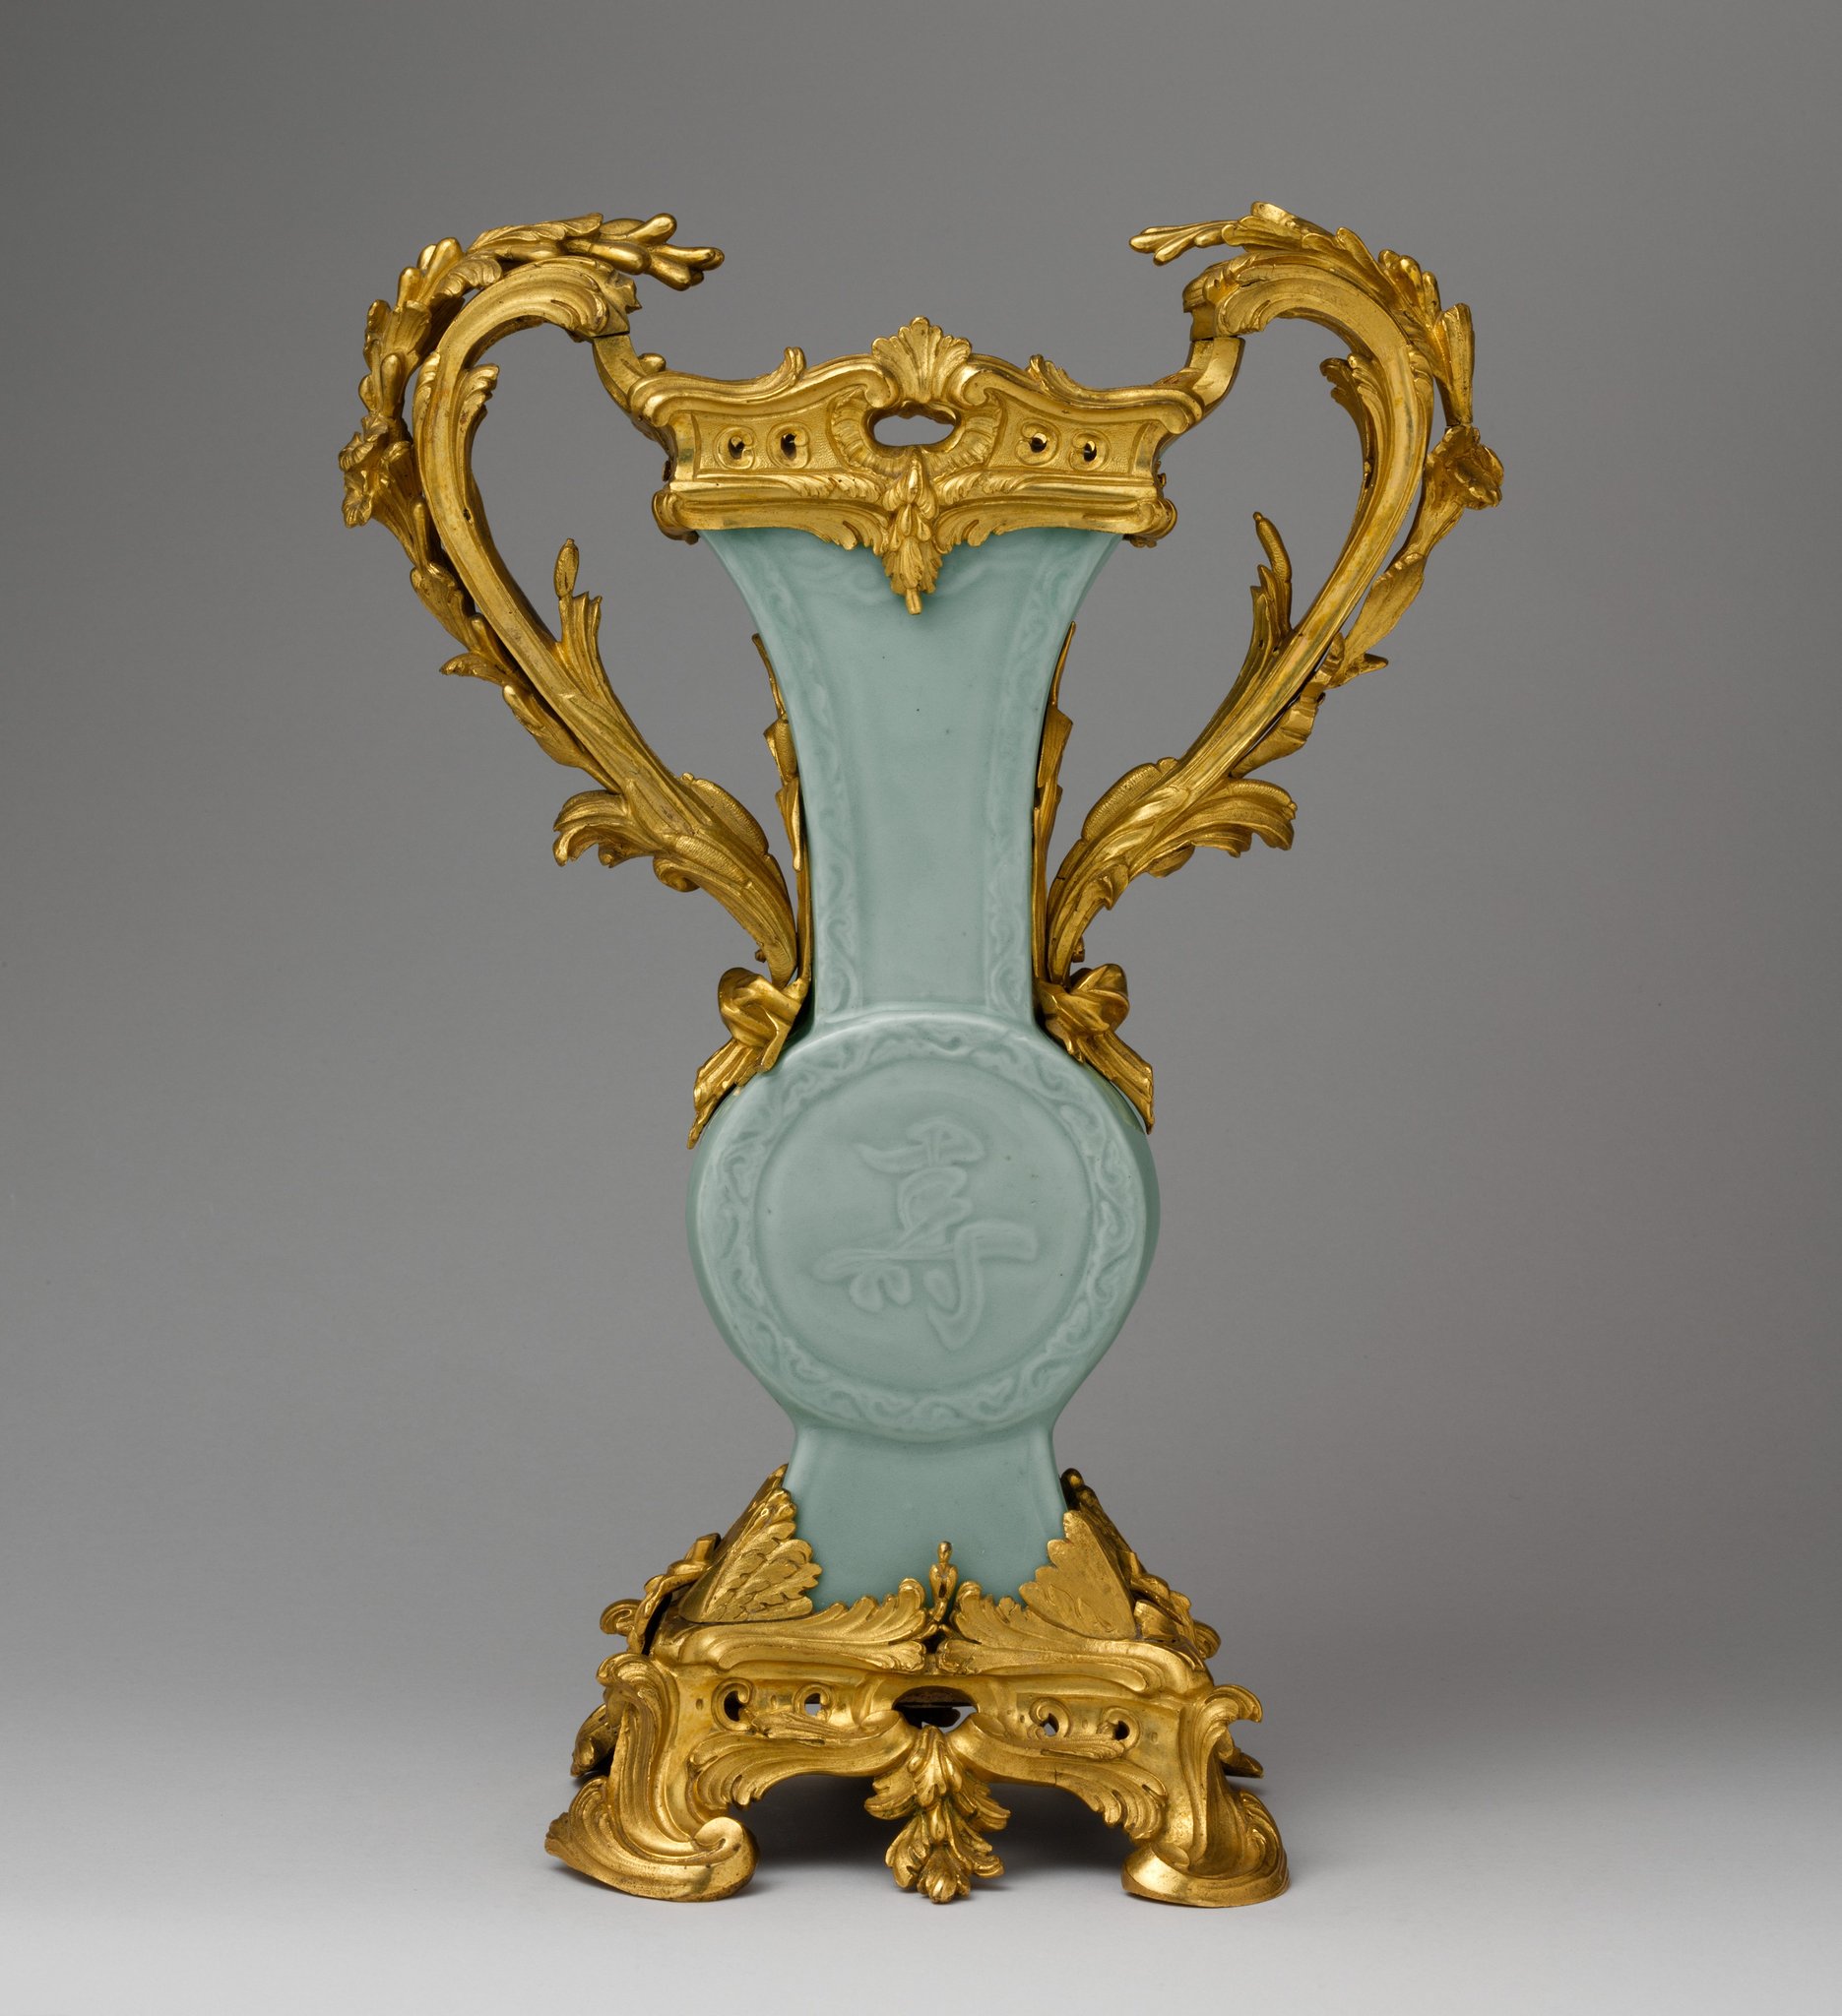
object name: vase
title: Pair of vases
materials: gilt bronze, hard paste porcelain